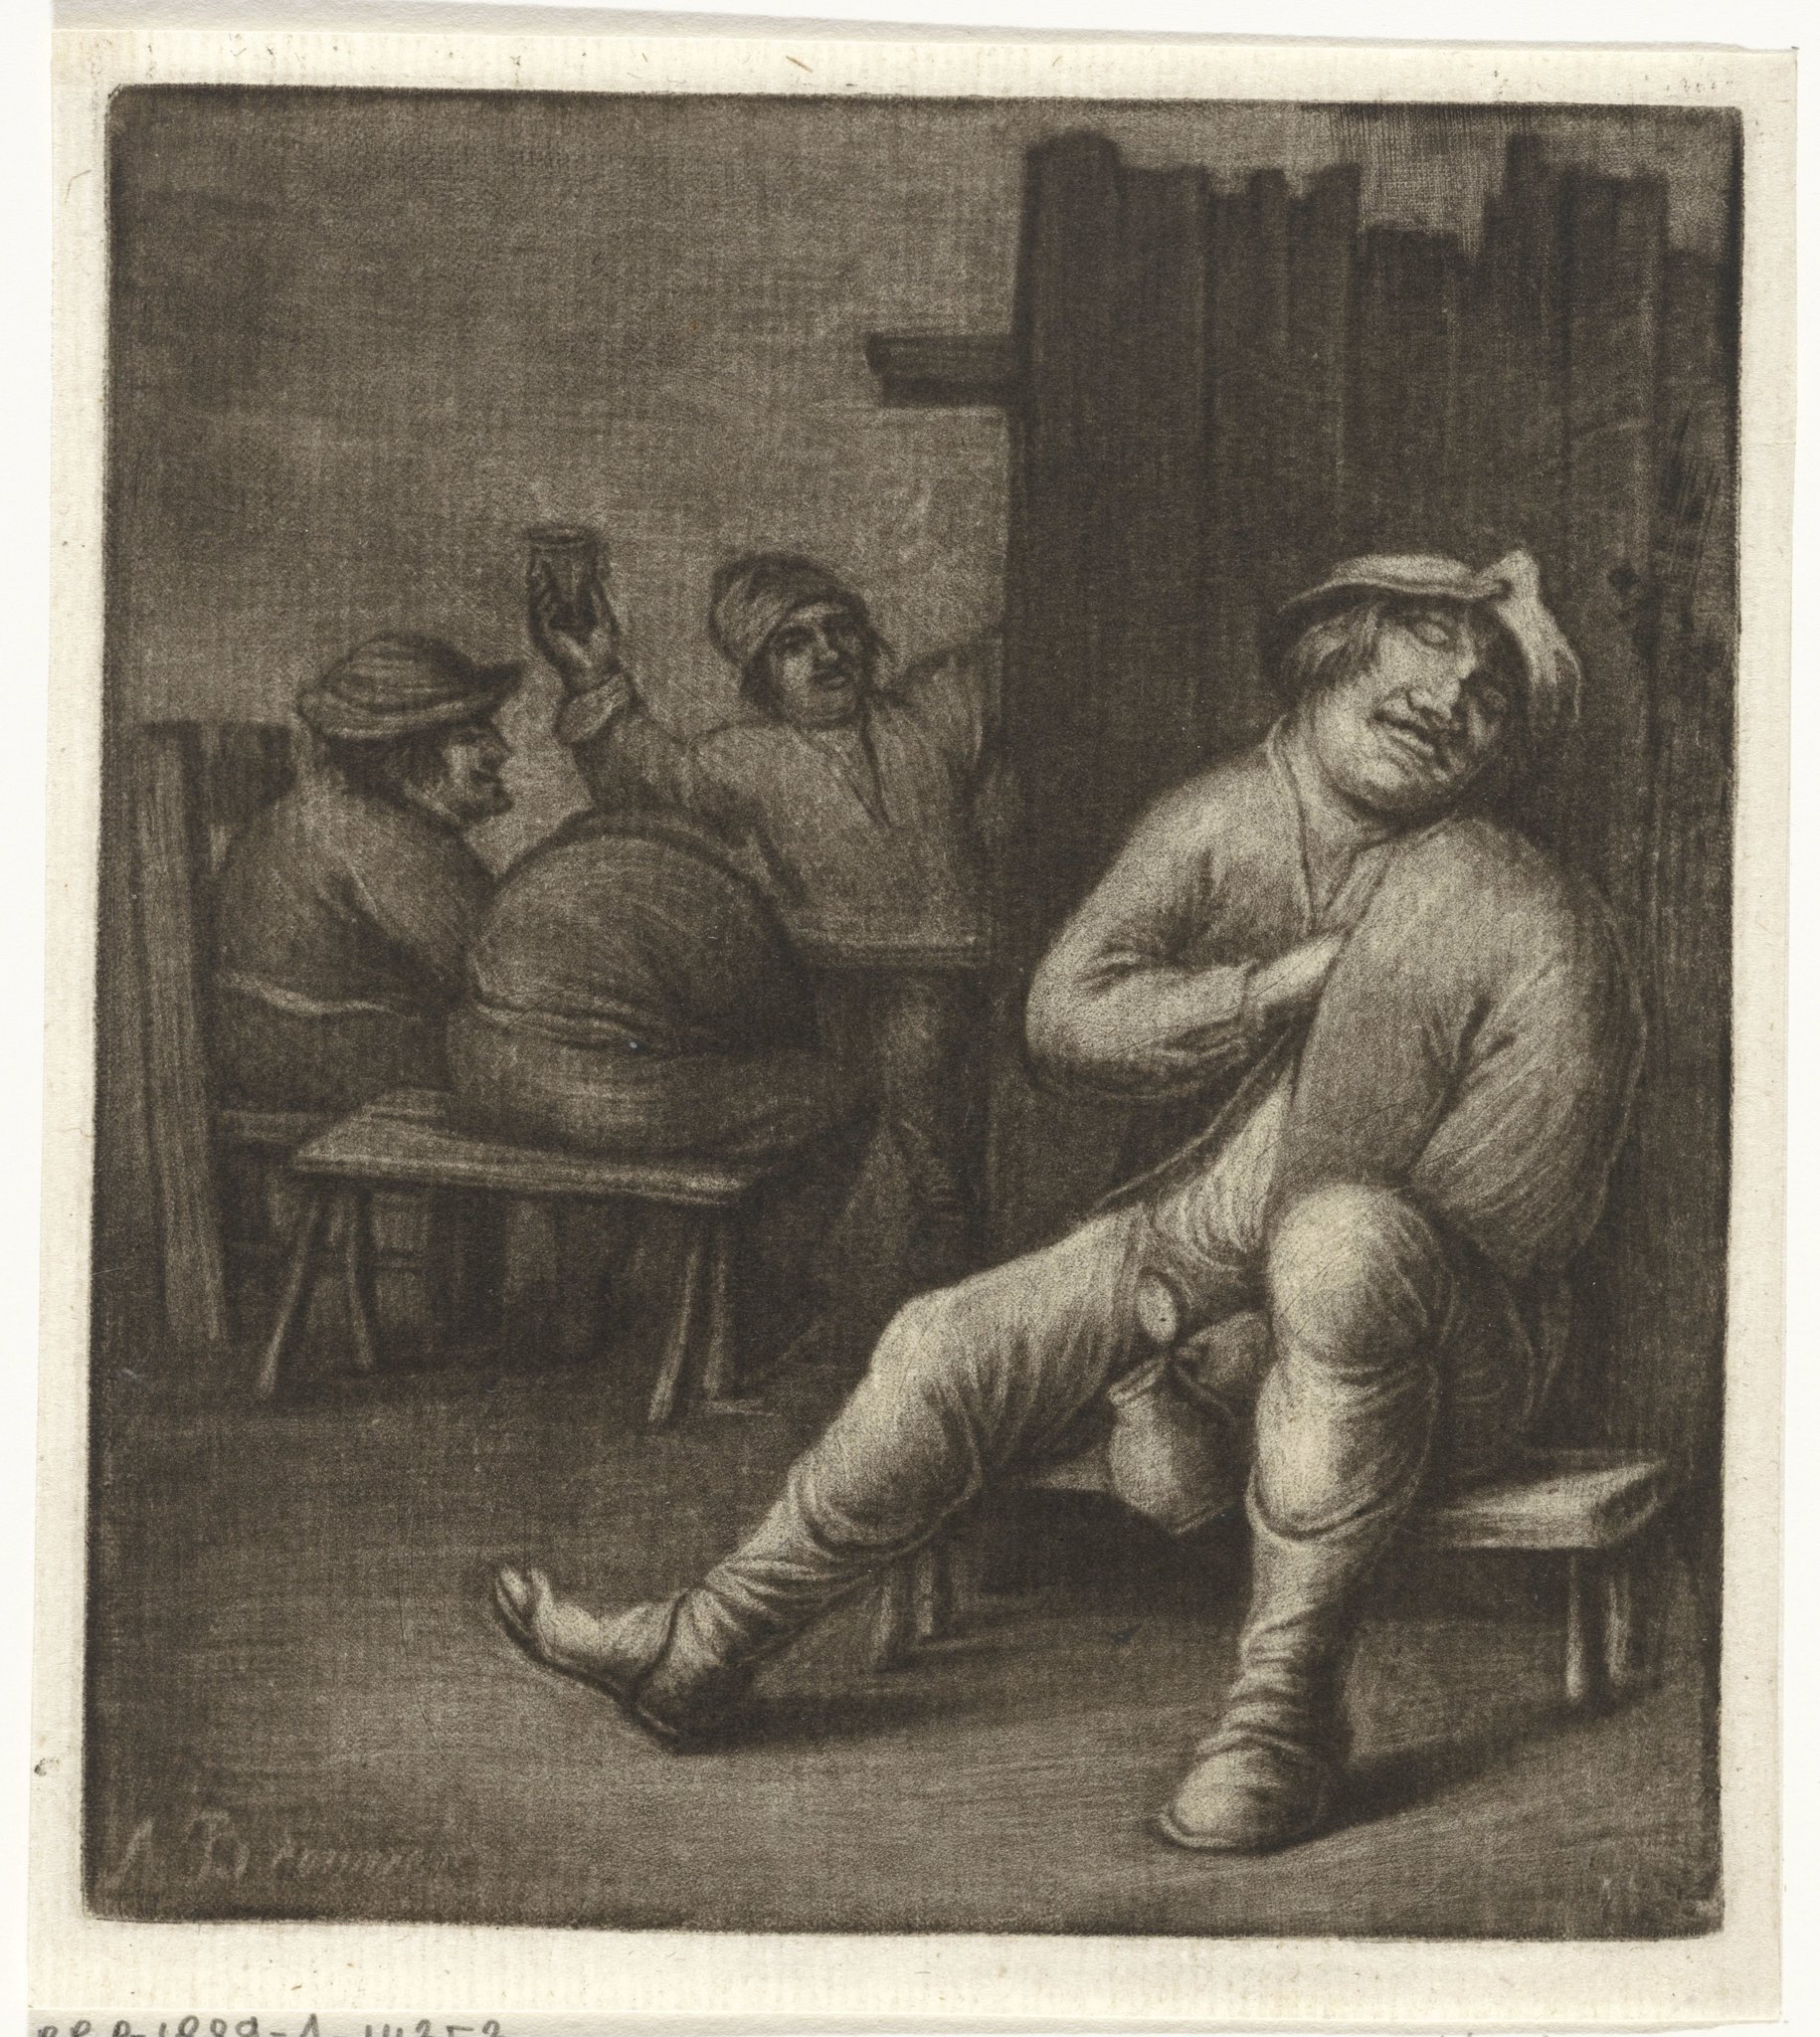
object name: print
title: Slapende man in een herberg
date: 1723-1789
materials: paper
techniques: mezzotint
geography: dordrecht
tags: inn, coffee-house, public house, etc., sleeping; unconsciousness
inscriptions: collector's mark: Lugt 2228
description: In een herberg zit een man te slapen tegen een houten schot, in zijn hand een bierpul. Op de achtergrond drie mannen rond een tafel.